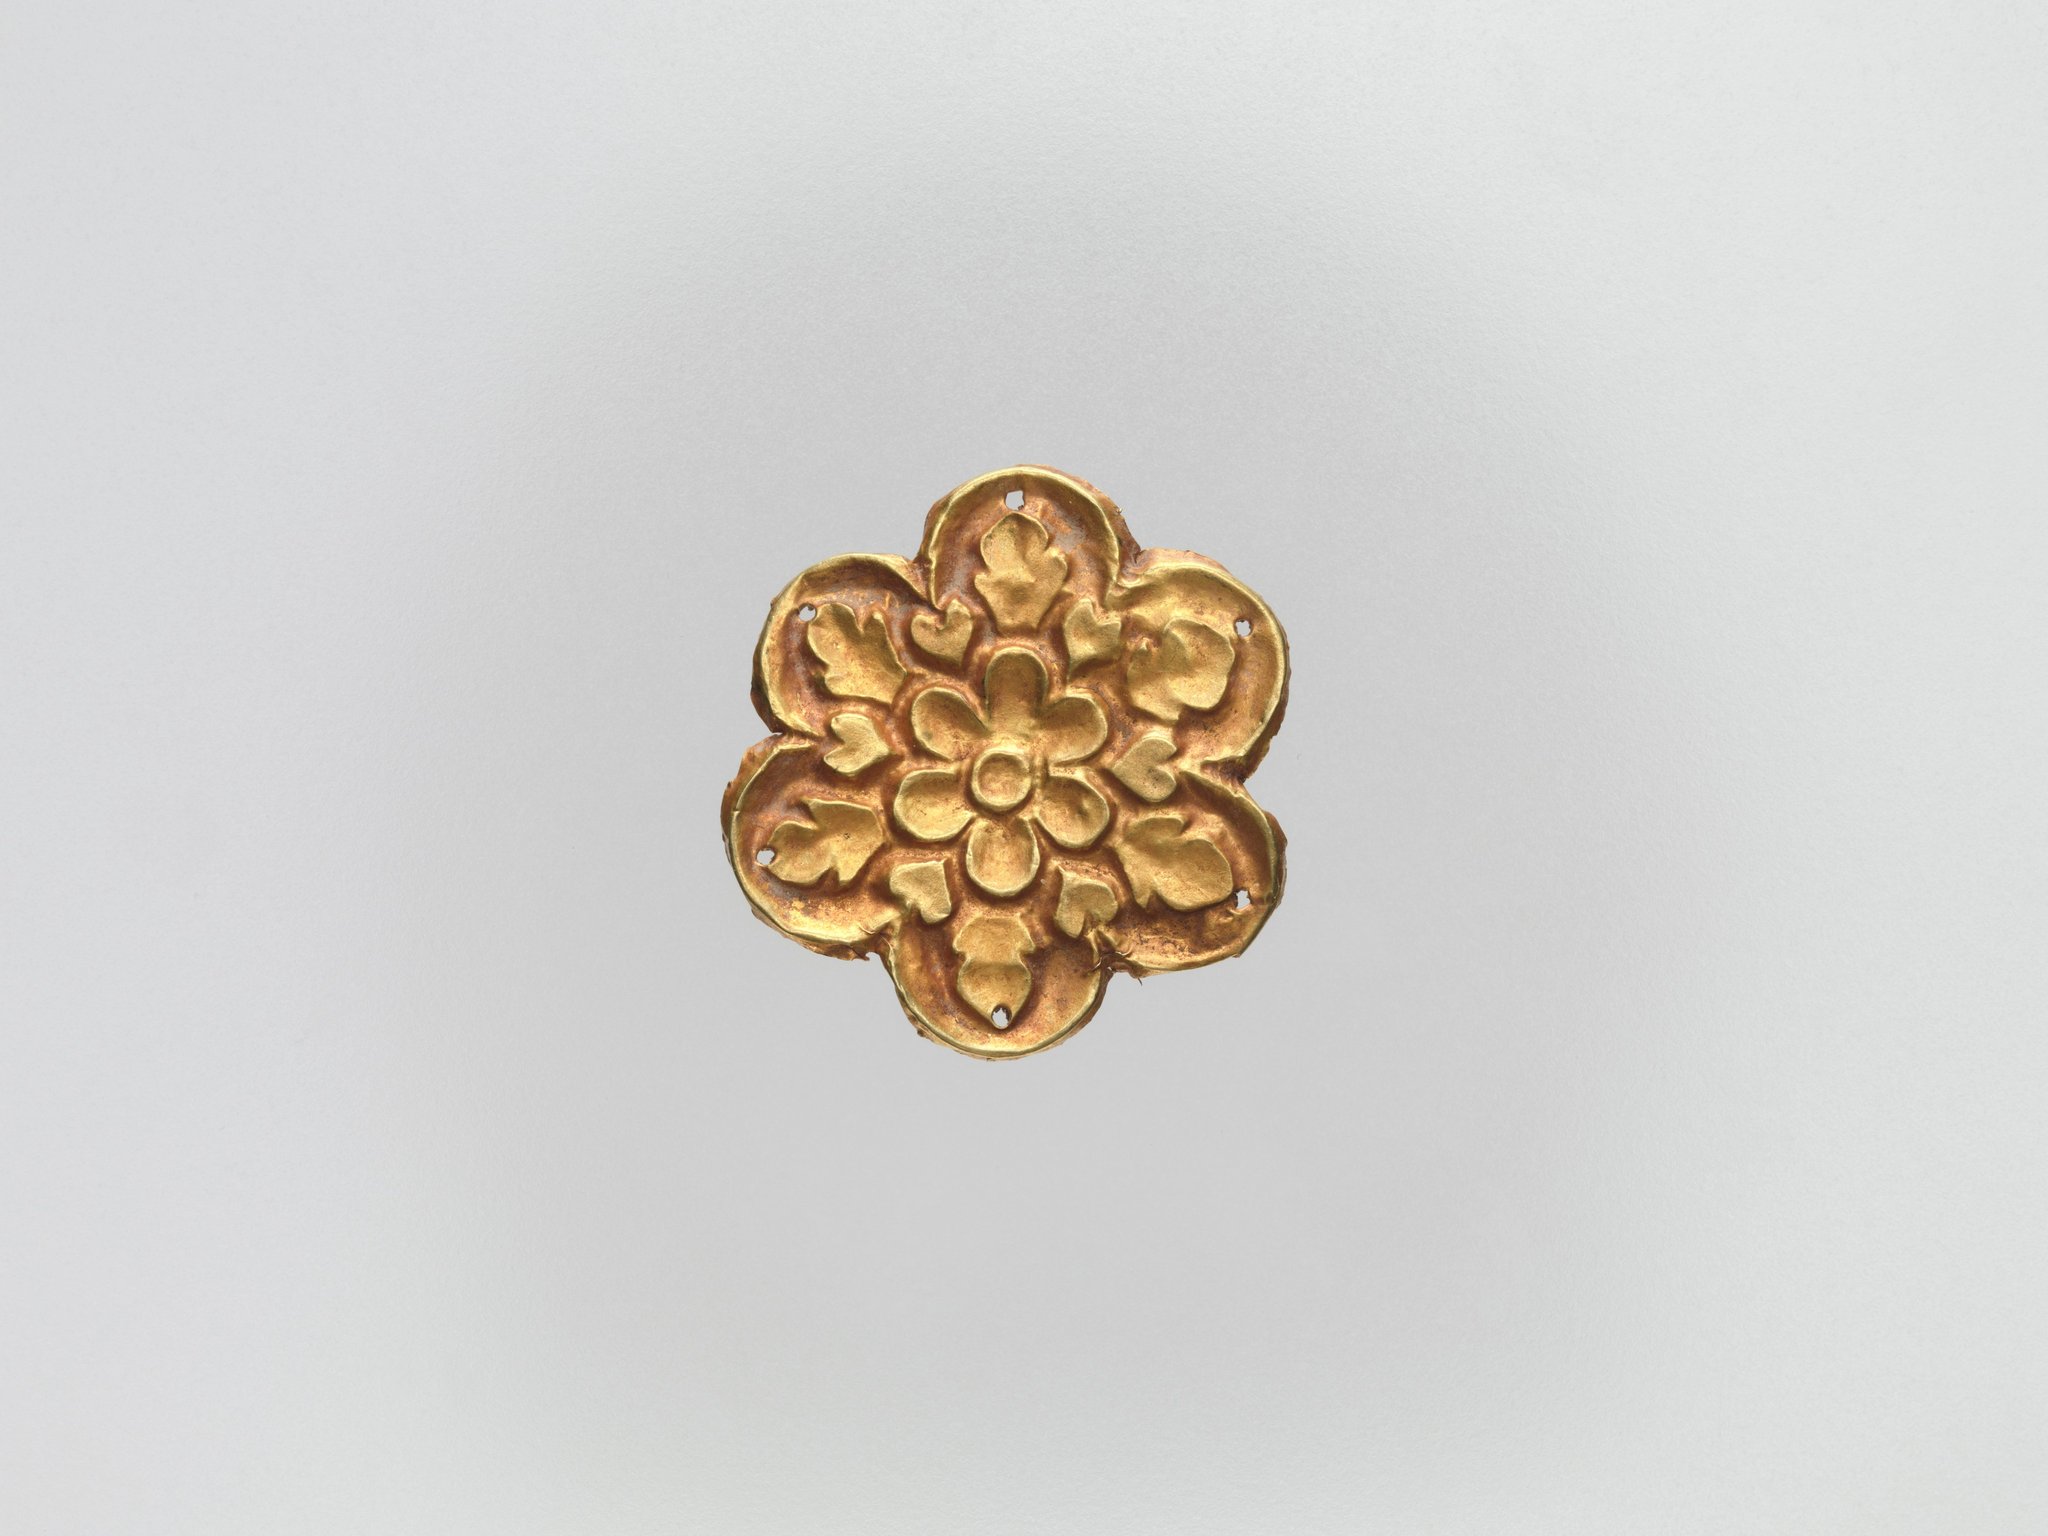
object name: garment plaque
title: Flower-Shaped Clothing Plaque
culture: chinese or central asian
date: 601-900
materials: gold